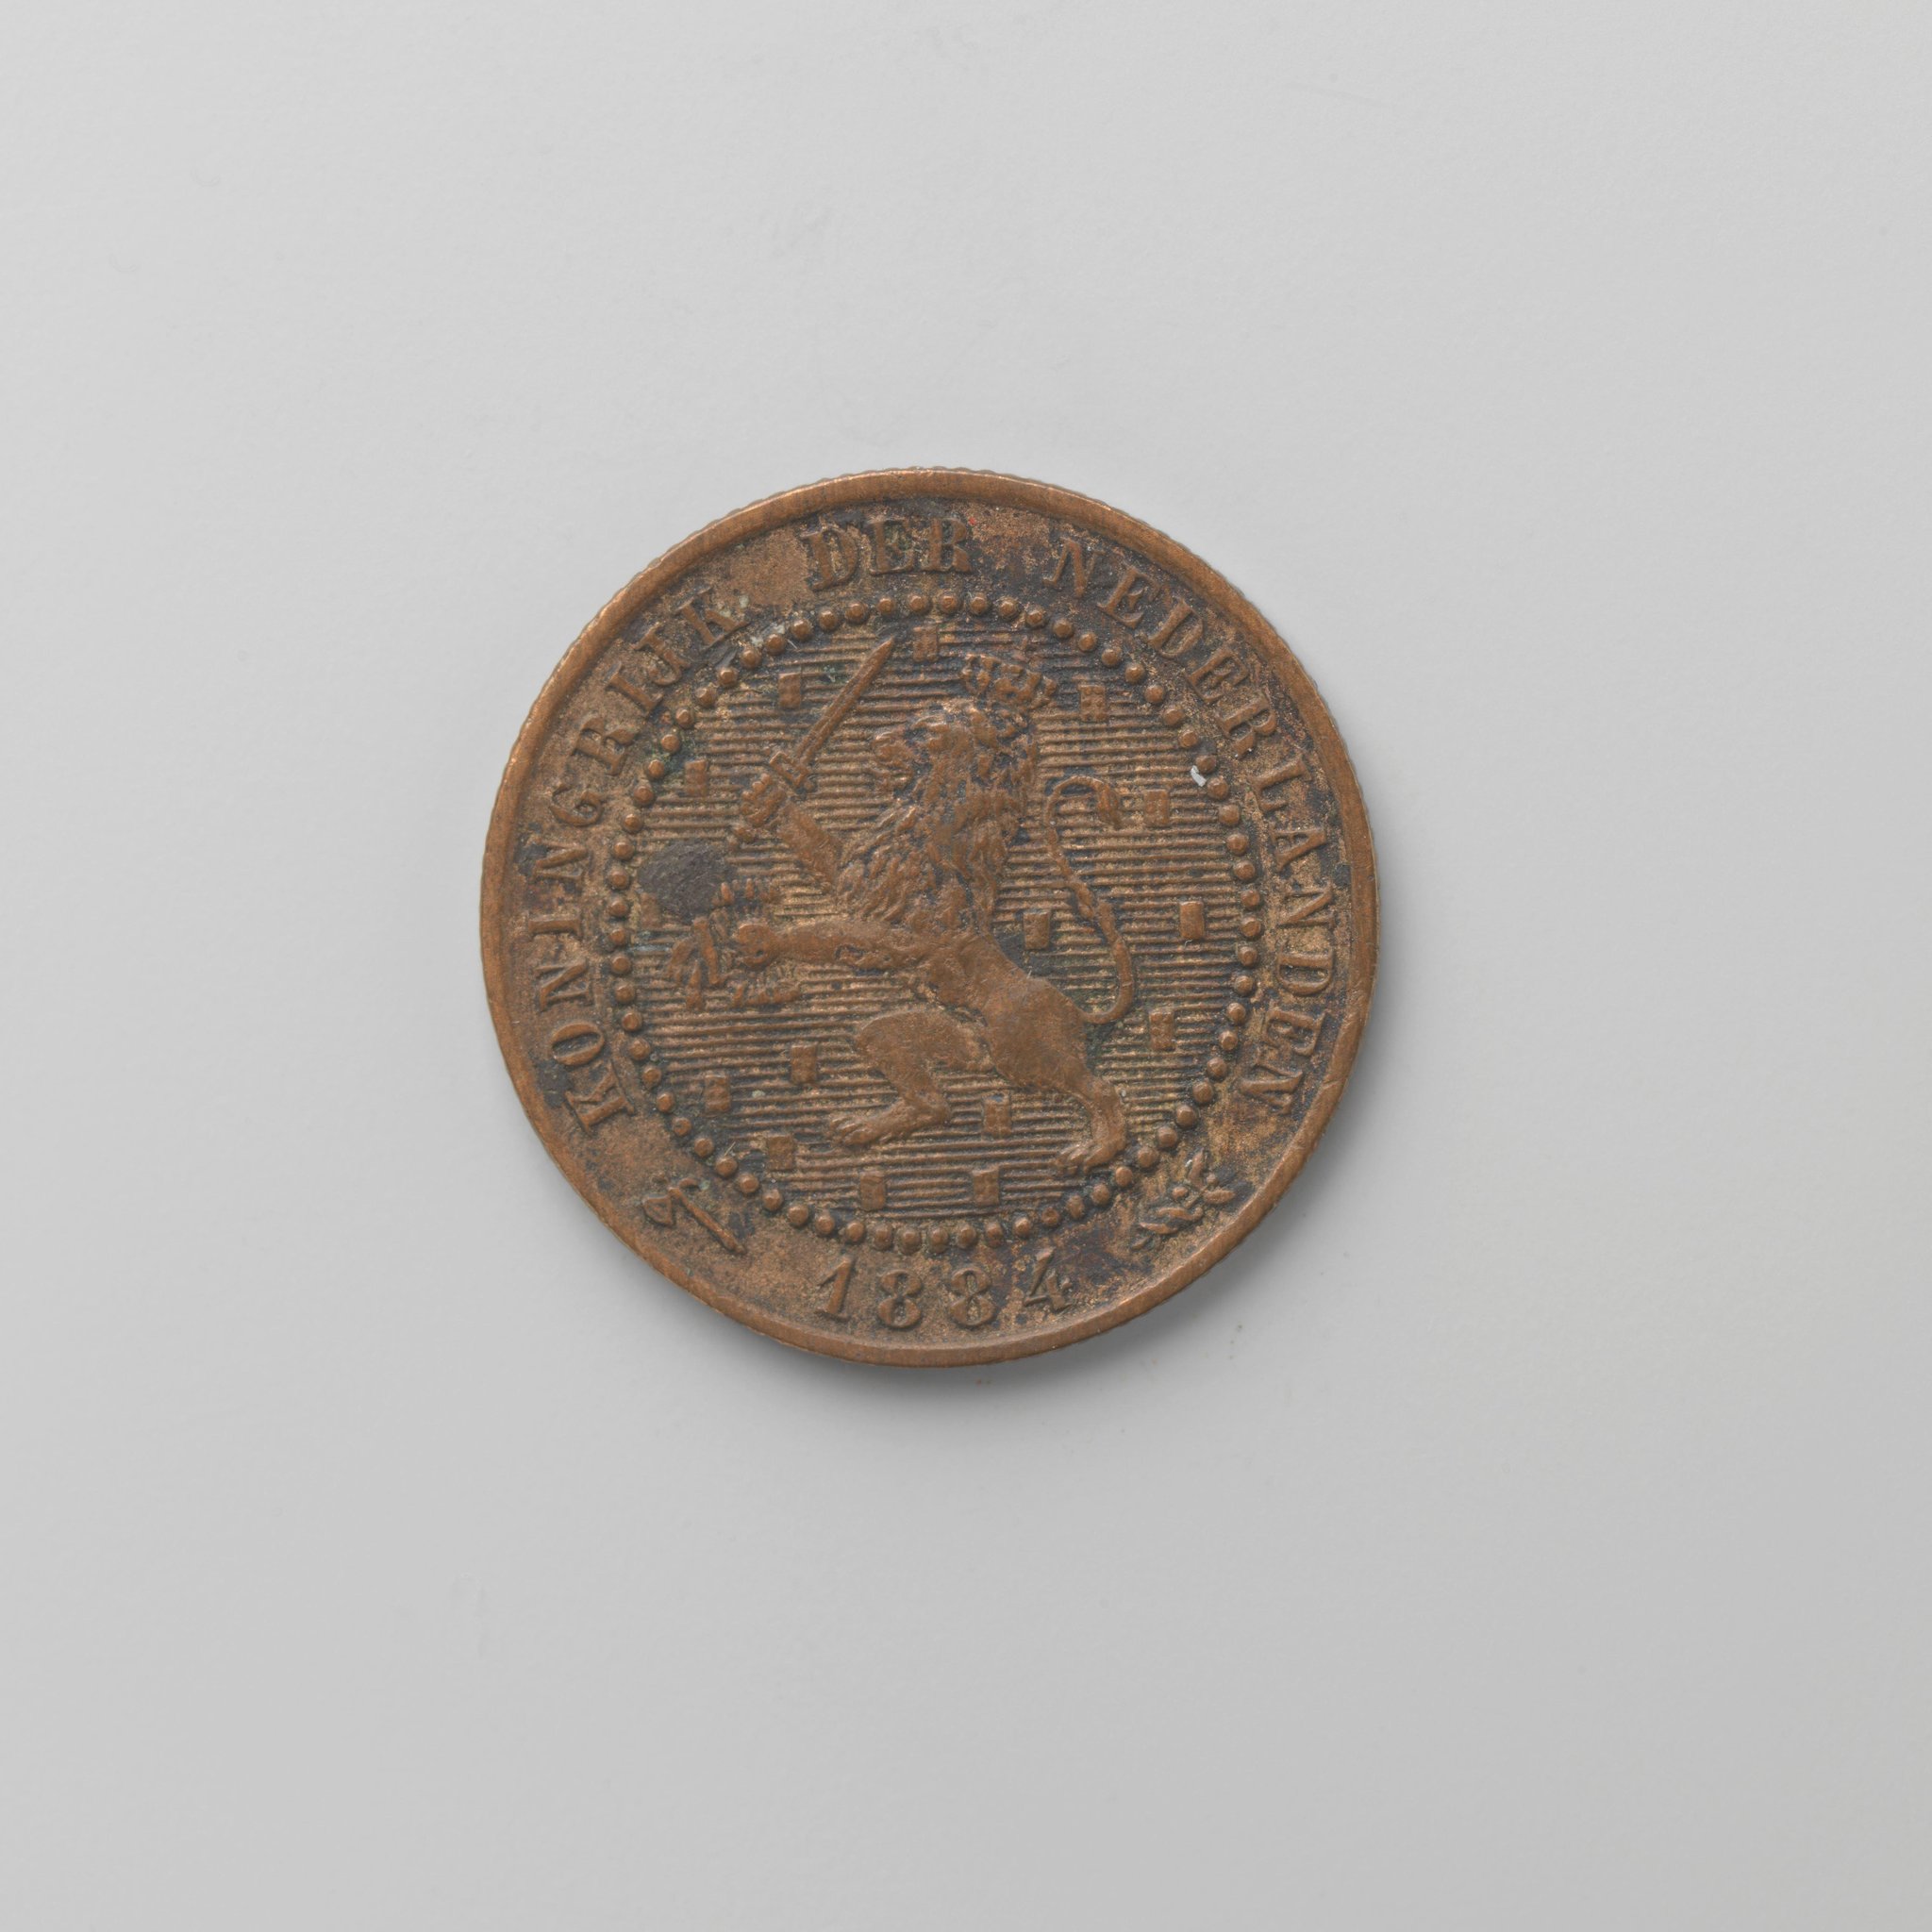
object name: coin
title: Nederlandse cent, 1884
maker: willem iii (koning der nederlanden)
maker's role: koning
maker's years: 1817-1890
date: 1884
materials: bronze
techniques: striking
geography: utrecht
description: Bronzen munt. Voorzijde: in een veld rijkswapen. Jaartal onderaan in omschrift. Keerzijde: binnen twee samengebonden oranjetakken waarde-aanduiding 1 cent. Kartelrand.